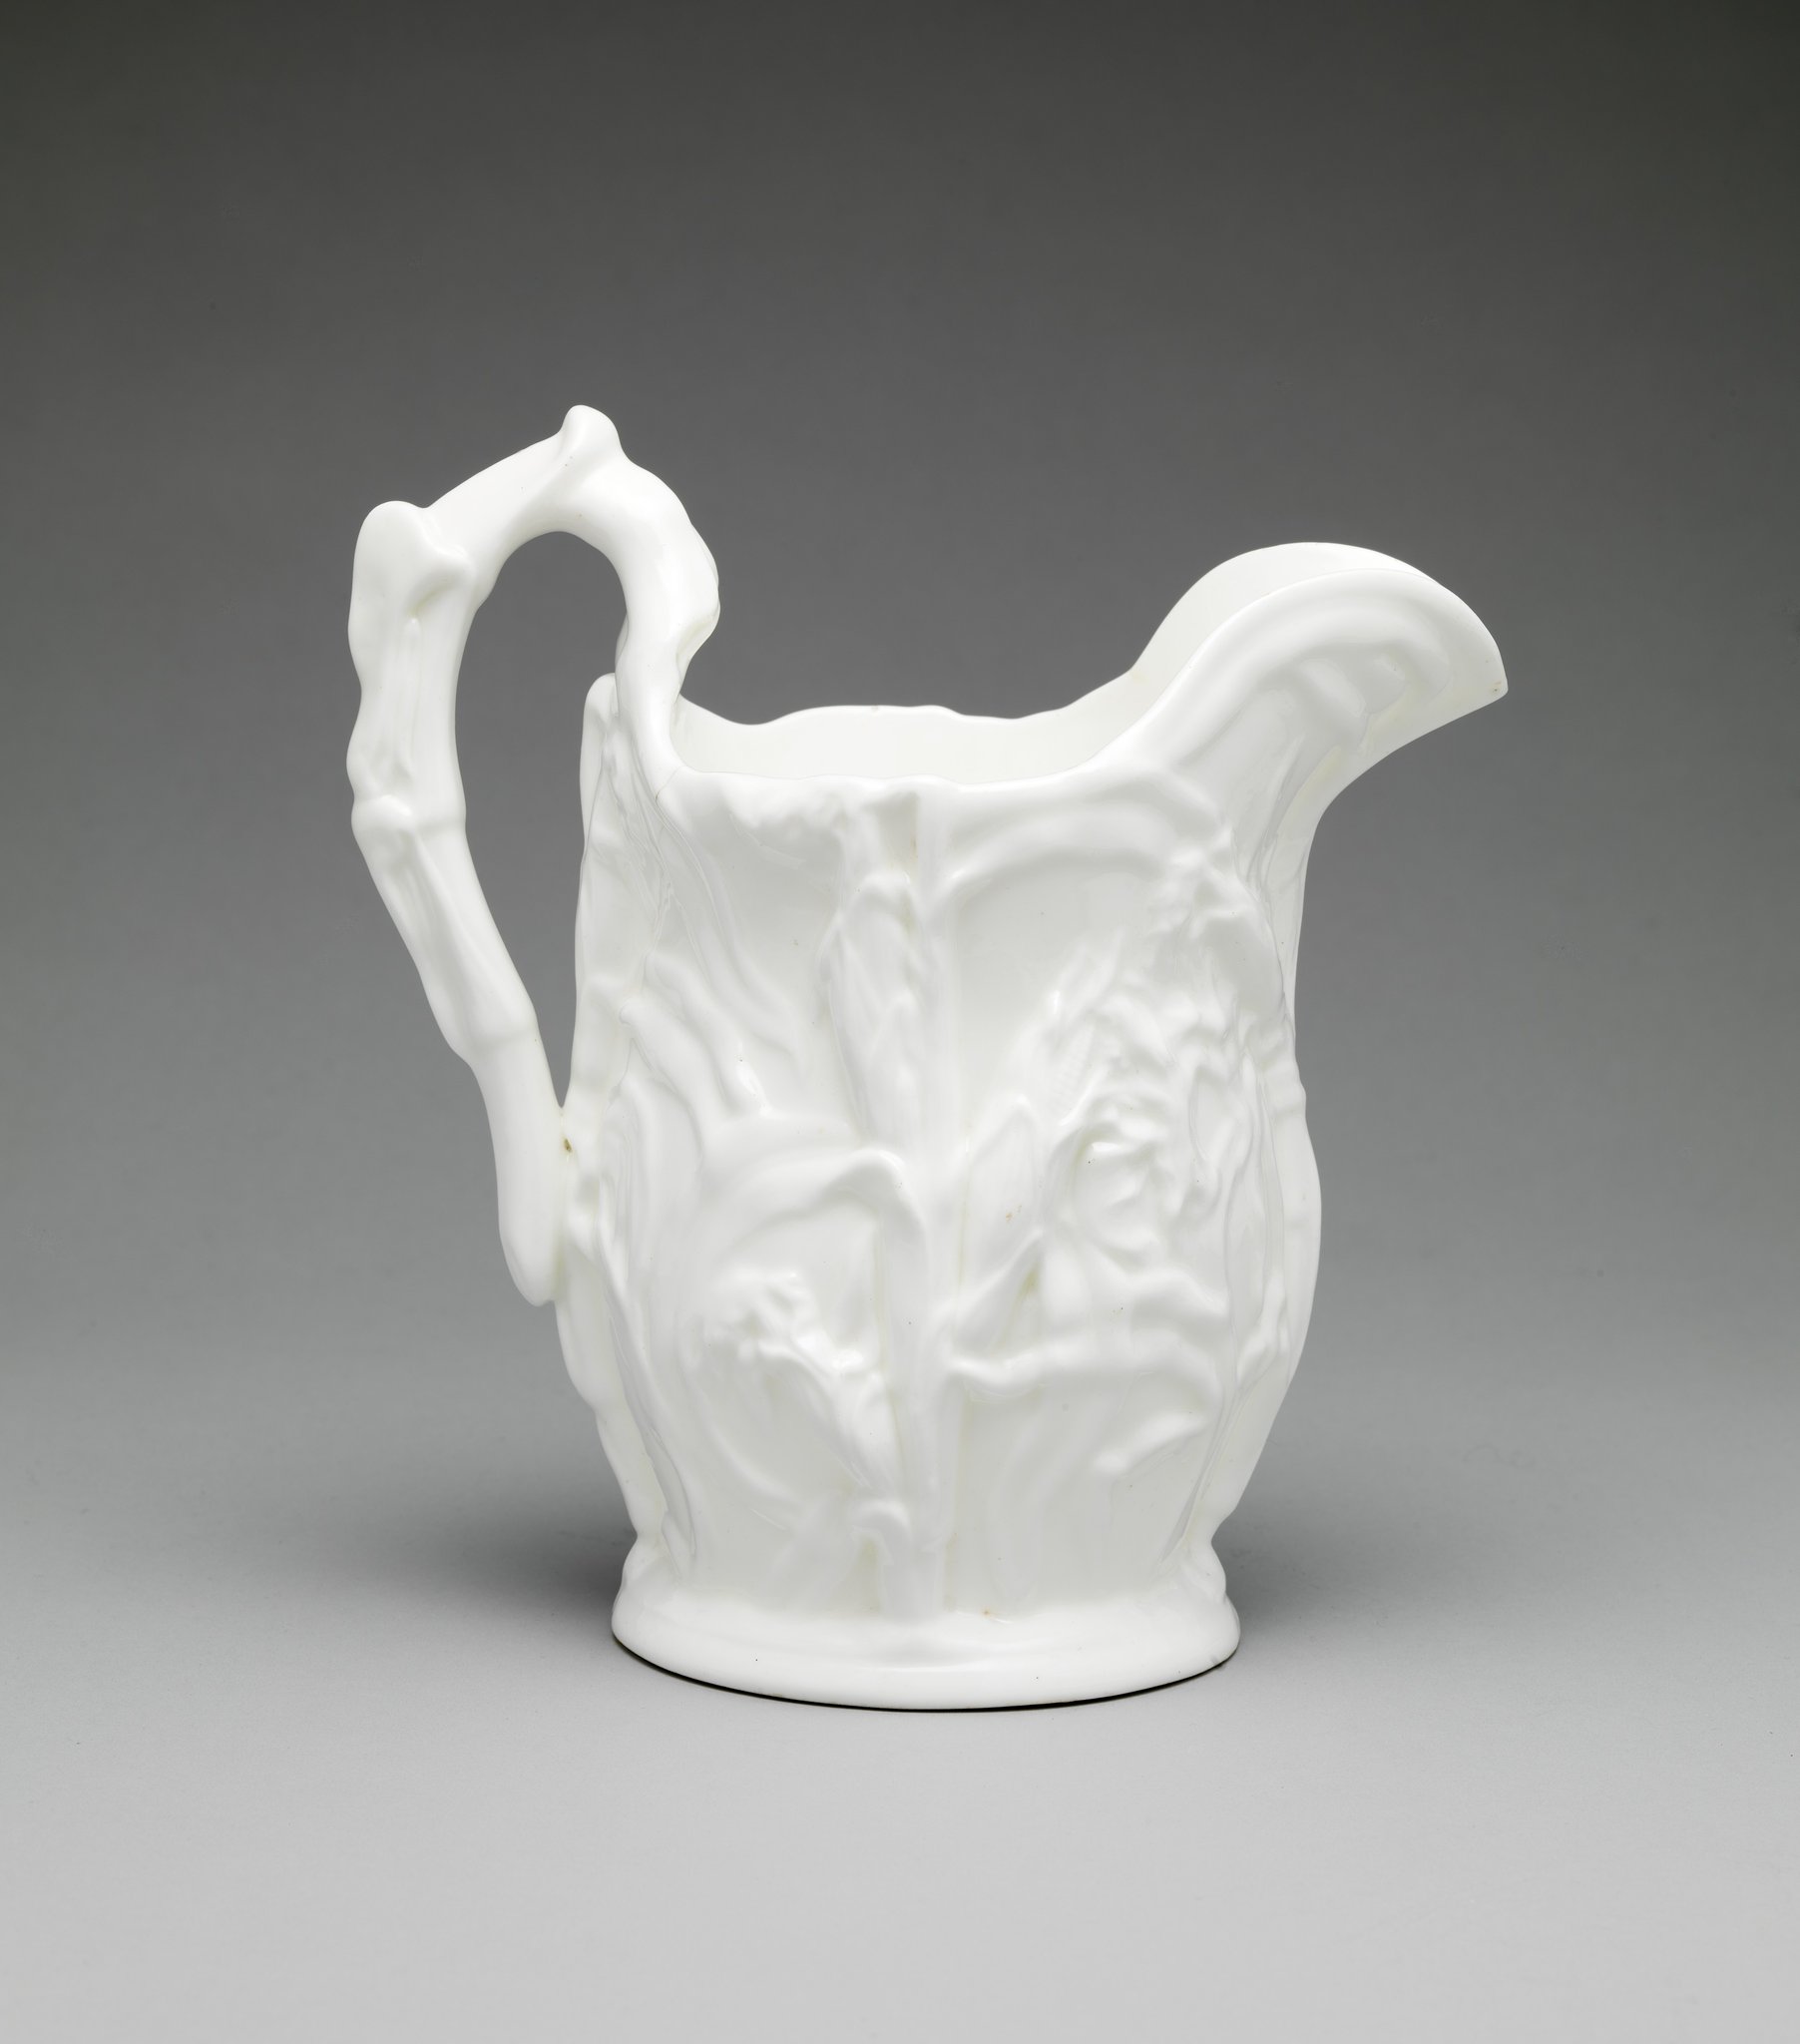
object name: pitcher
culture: american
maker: southern porcelain company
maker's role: maker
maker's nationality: american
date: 1862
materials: porcelain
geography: united states